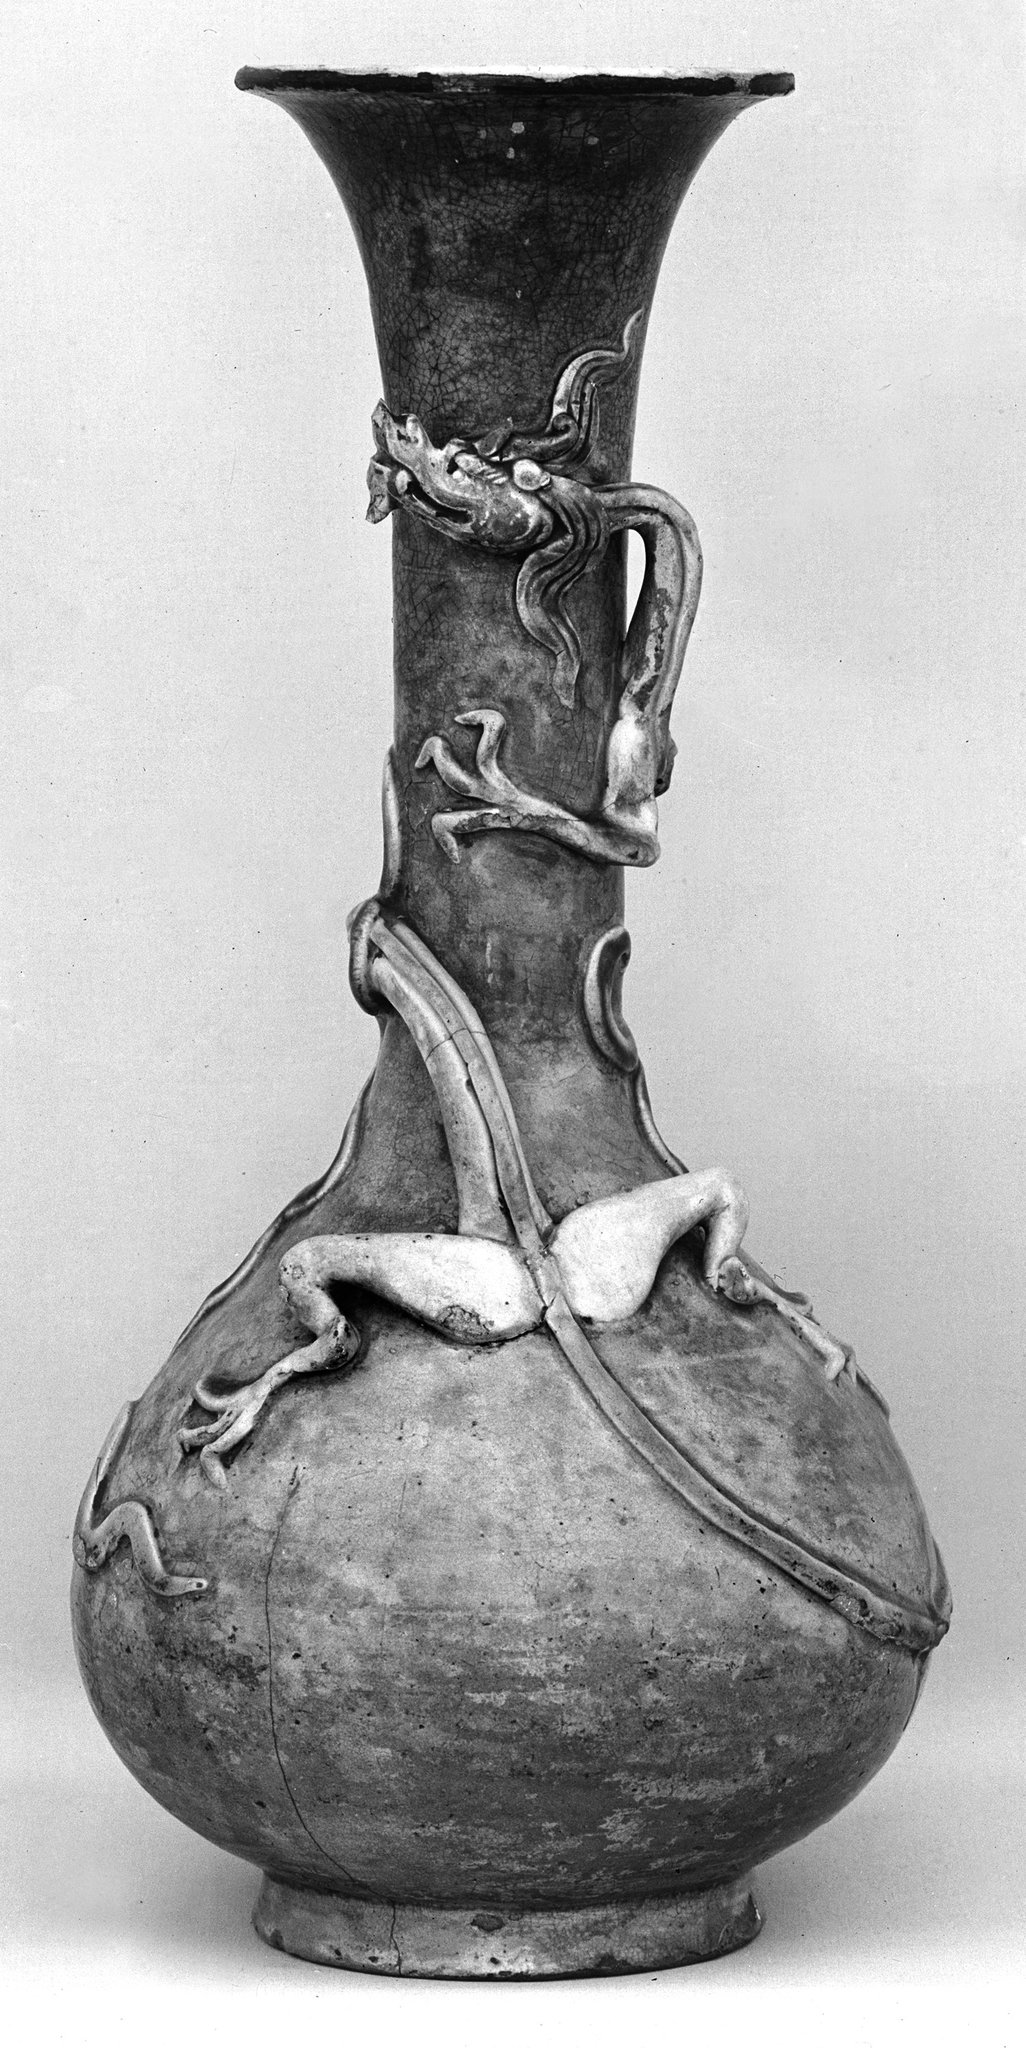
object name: vase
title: Vase with coiling dragon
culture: chinese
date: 1501-1600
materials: enamel, stoneware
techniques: polychrome, relief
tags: dragons